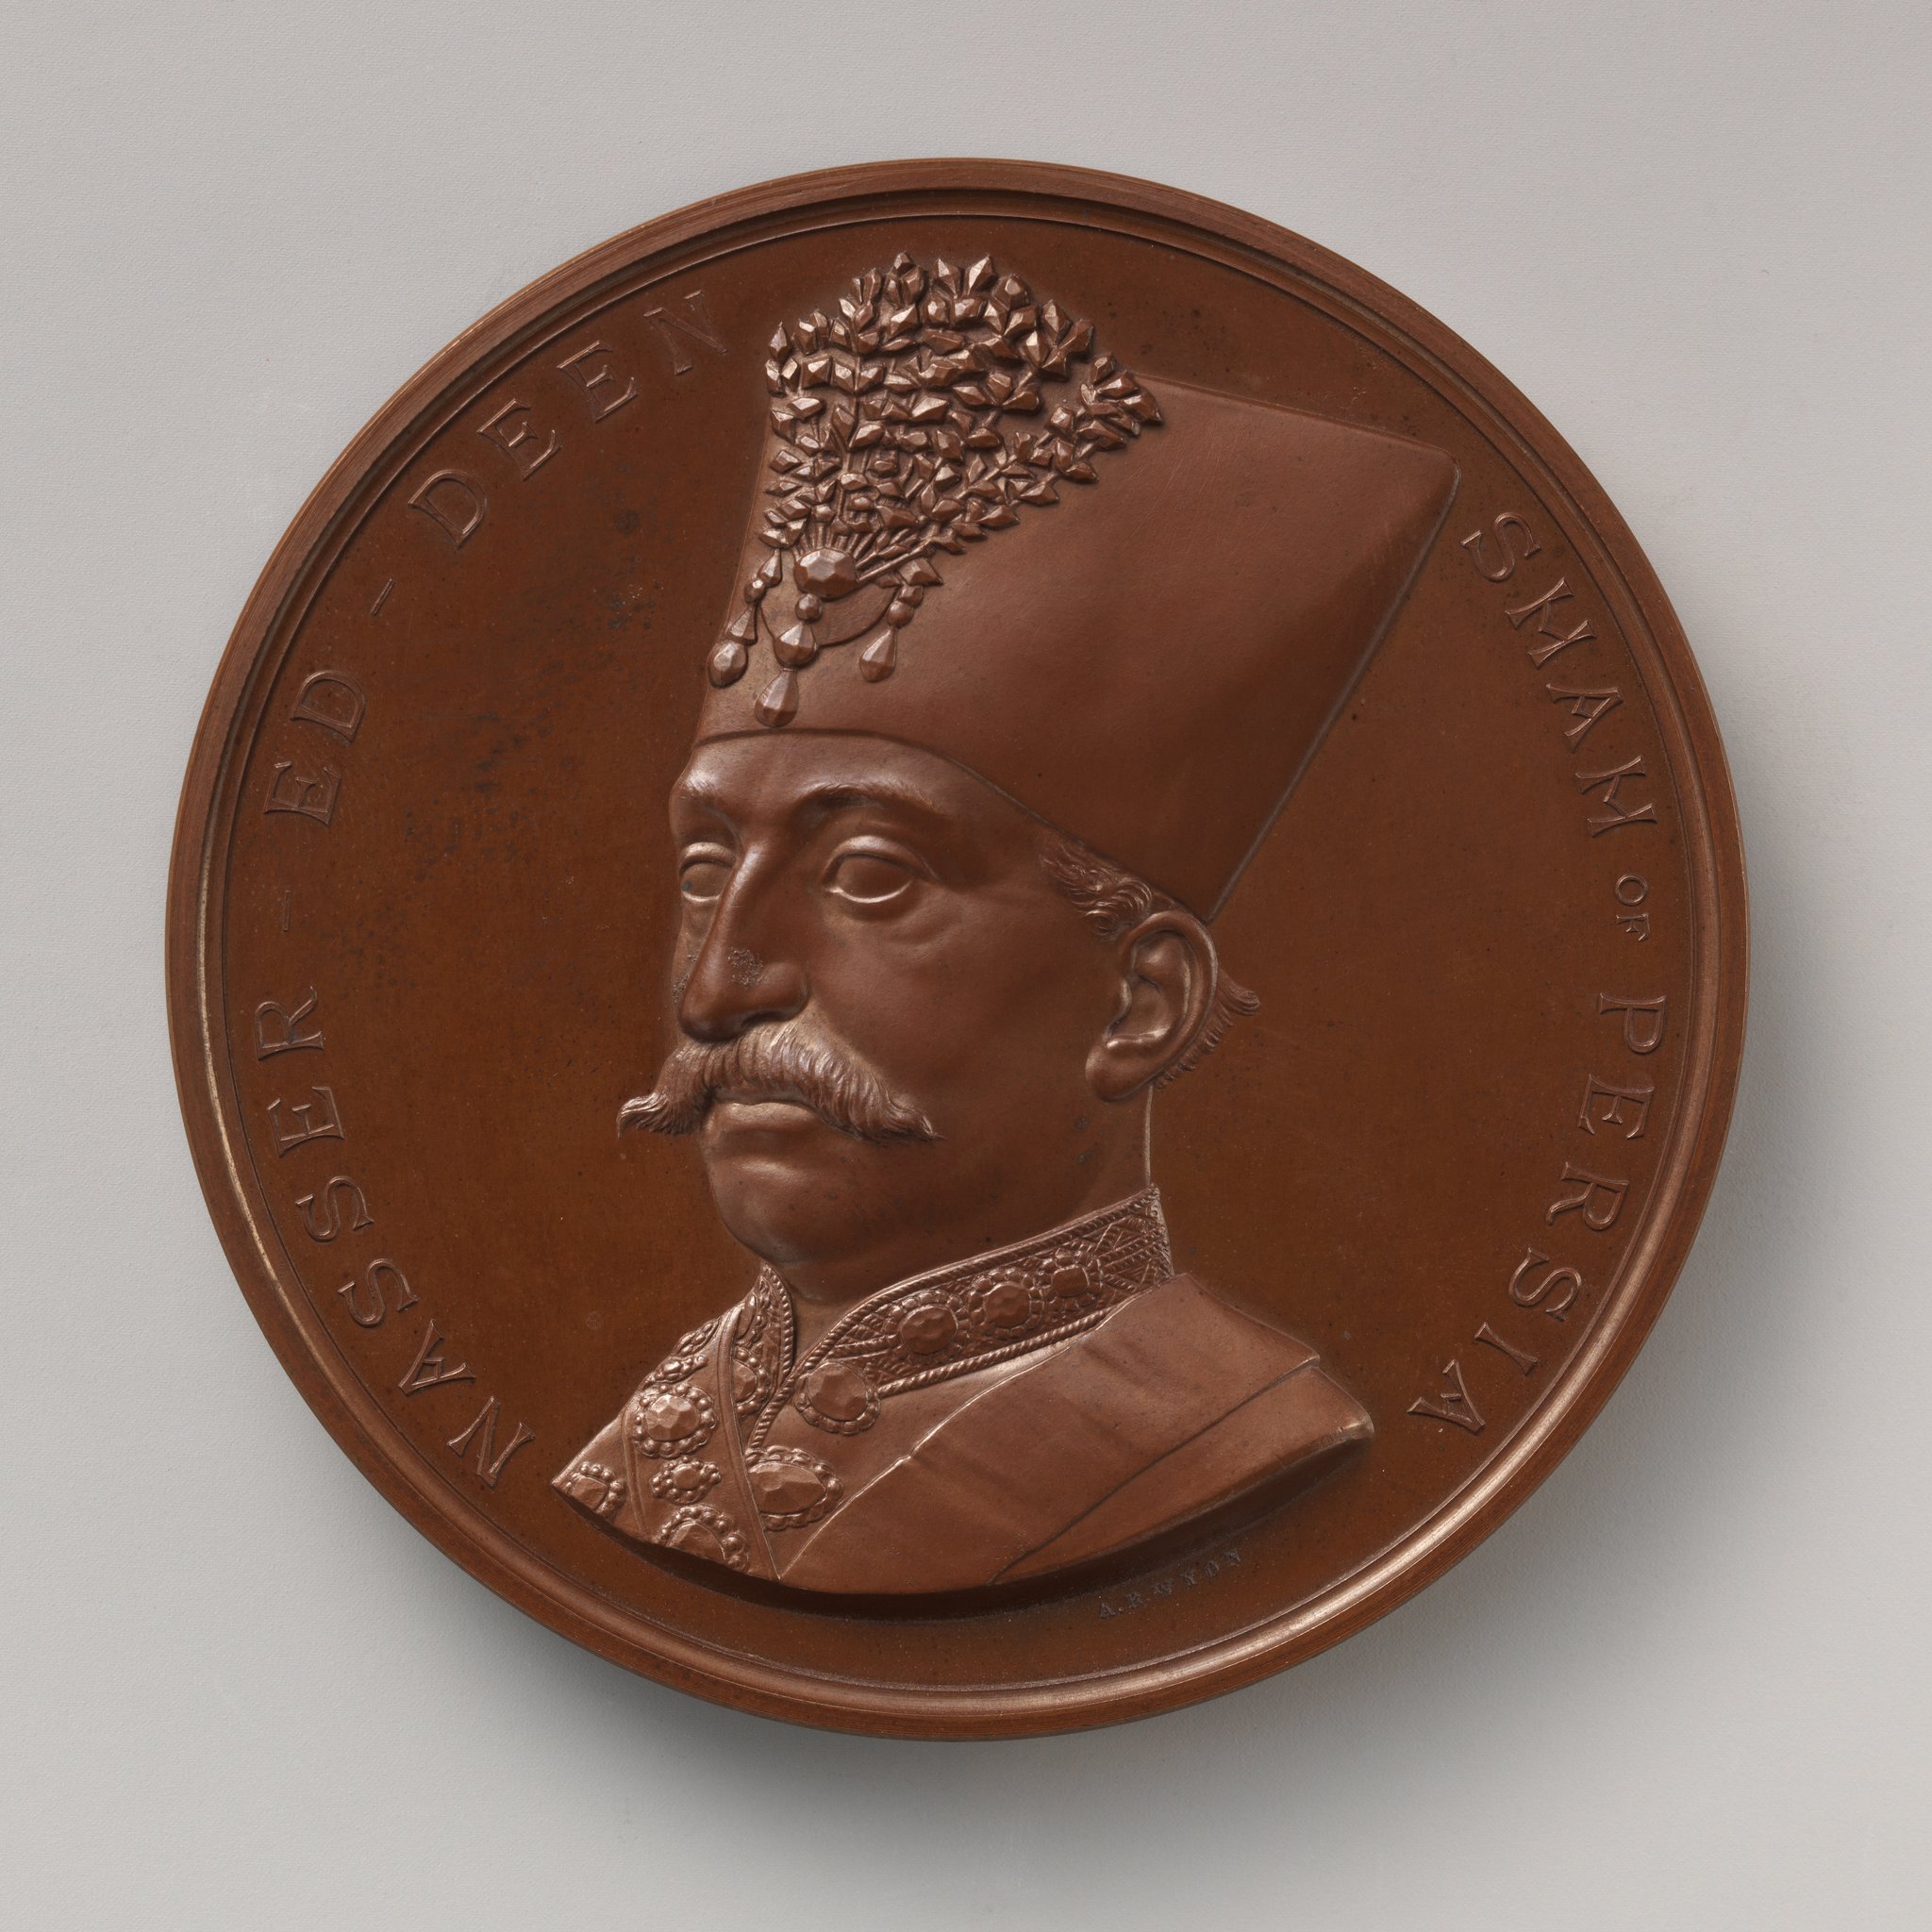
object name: medal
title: In Memory of the Visit of the Shah of Persia to the City of London, June 20, 1873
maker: alfred benjamin wyon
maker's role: artist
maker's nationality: british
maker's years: 1837-1884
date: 1873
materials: bronze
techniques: struck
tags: men,portraits